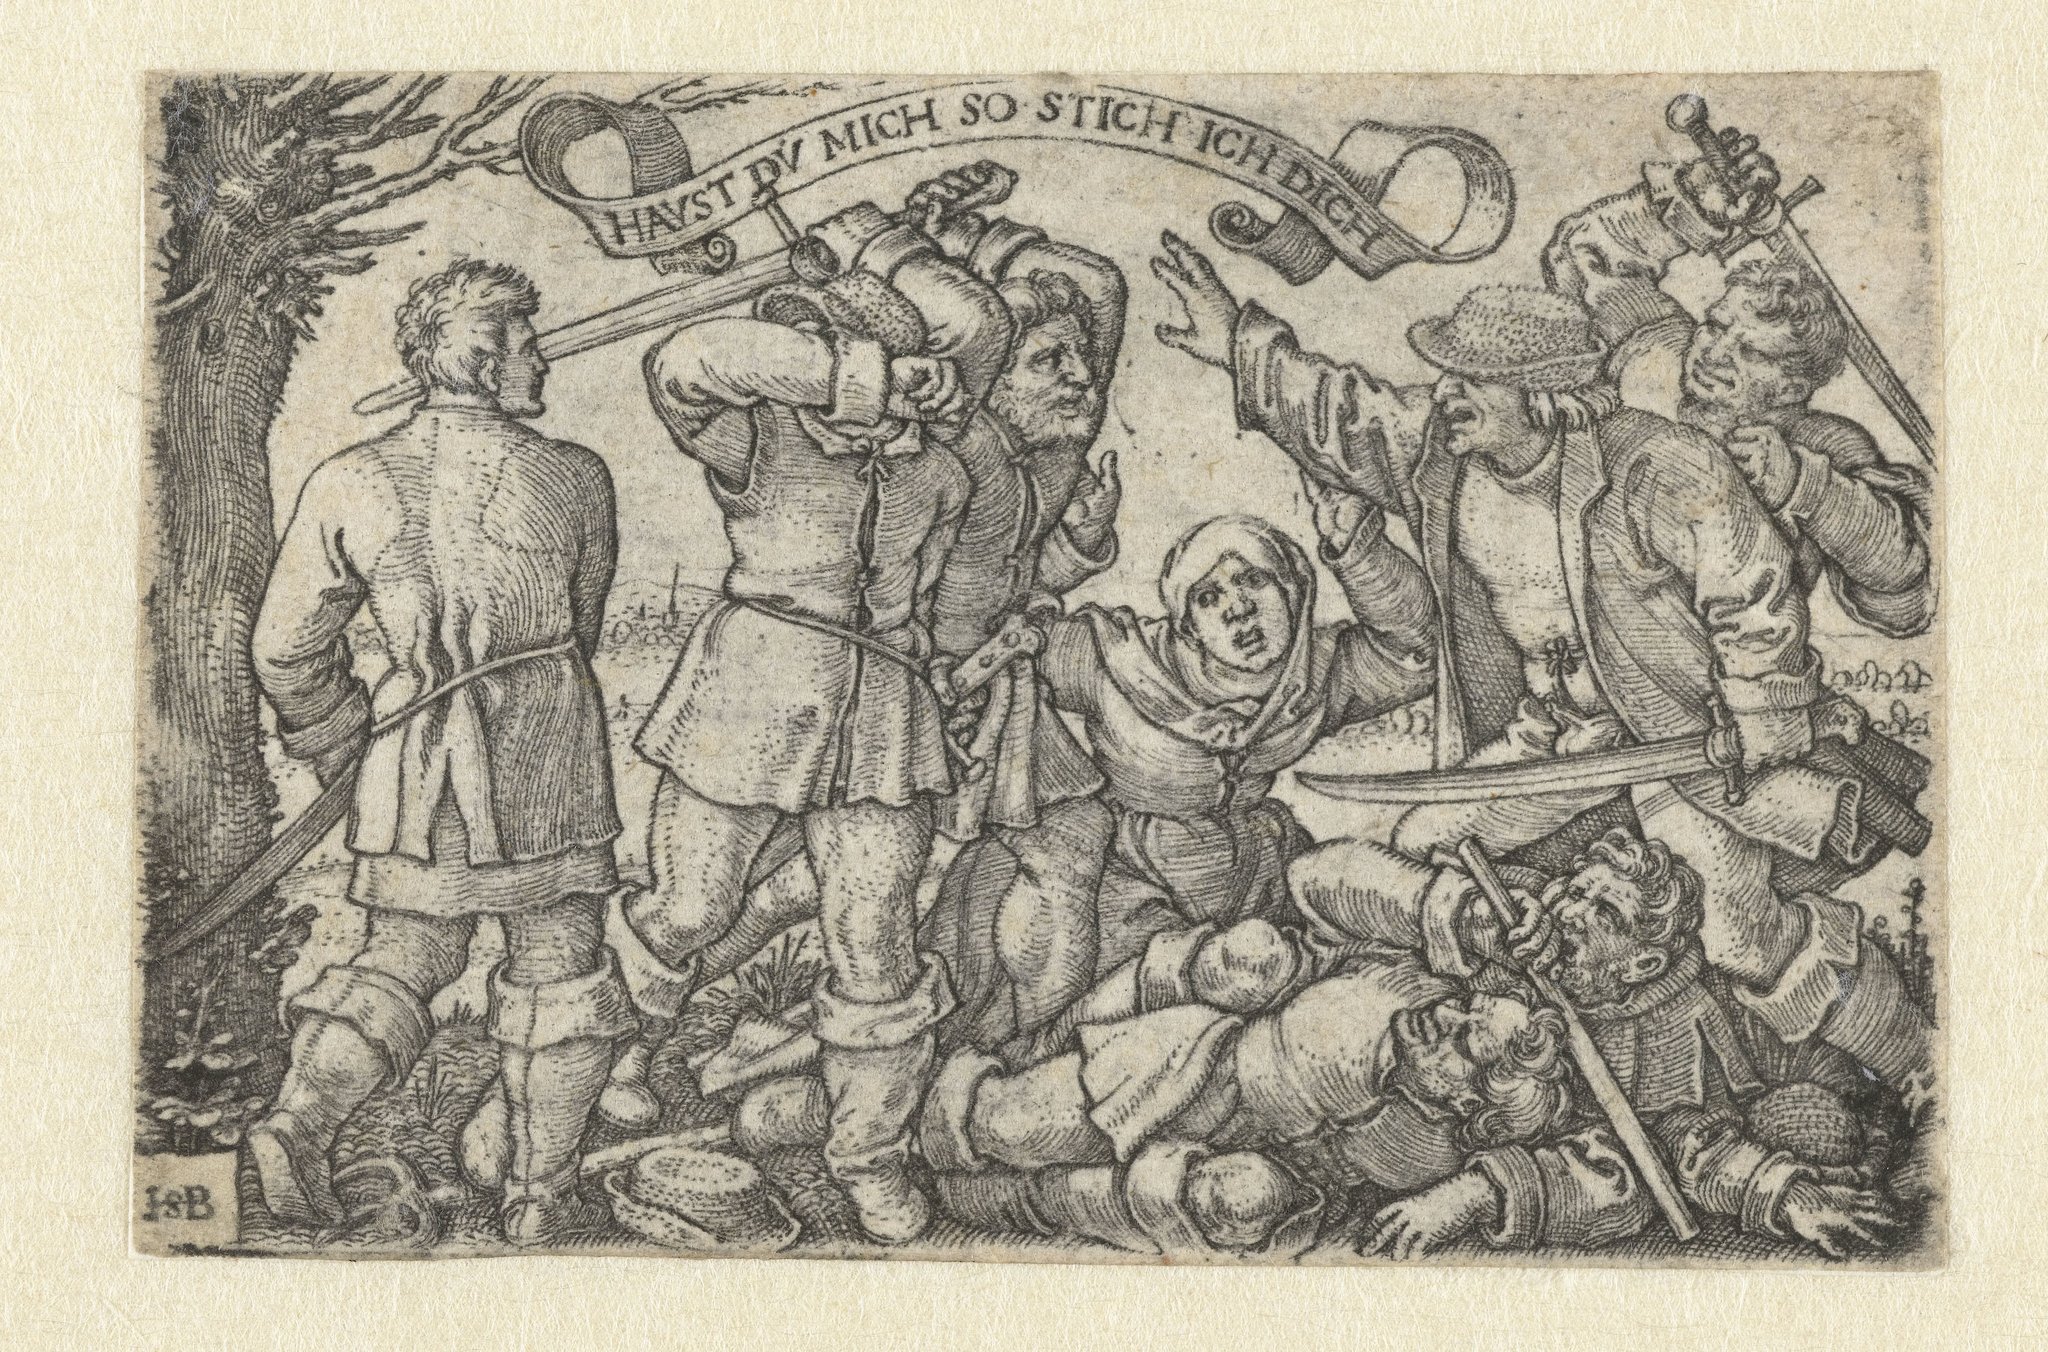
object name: print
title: Havst dv mich so stich ich dich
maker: hans sebald beham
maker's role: designer, draughtsman, print maker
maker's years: 1500-1550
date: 1510-1550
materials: paper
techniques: engraving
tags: farmers, fighting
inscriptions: collector's mark: Lugt 11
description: Een boerin probeert twee vechtende groepjes boeren uit elkaar te houden. De mannen gaan elkaar met zwaarden te lijf.